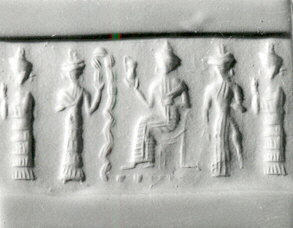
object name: cylinder seal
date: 1001-1333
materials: mineral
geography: mesopotamia